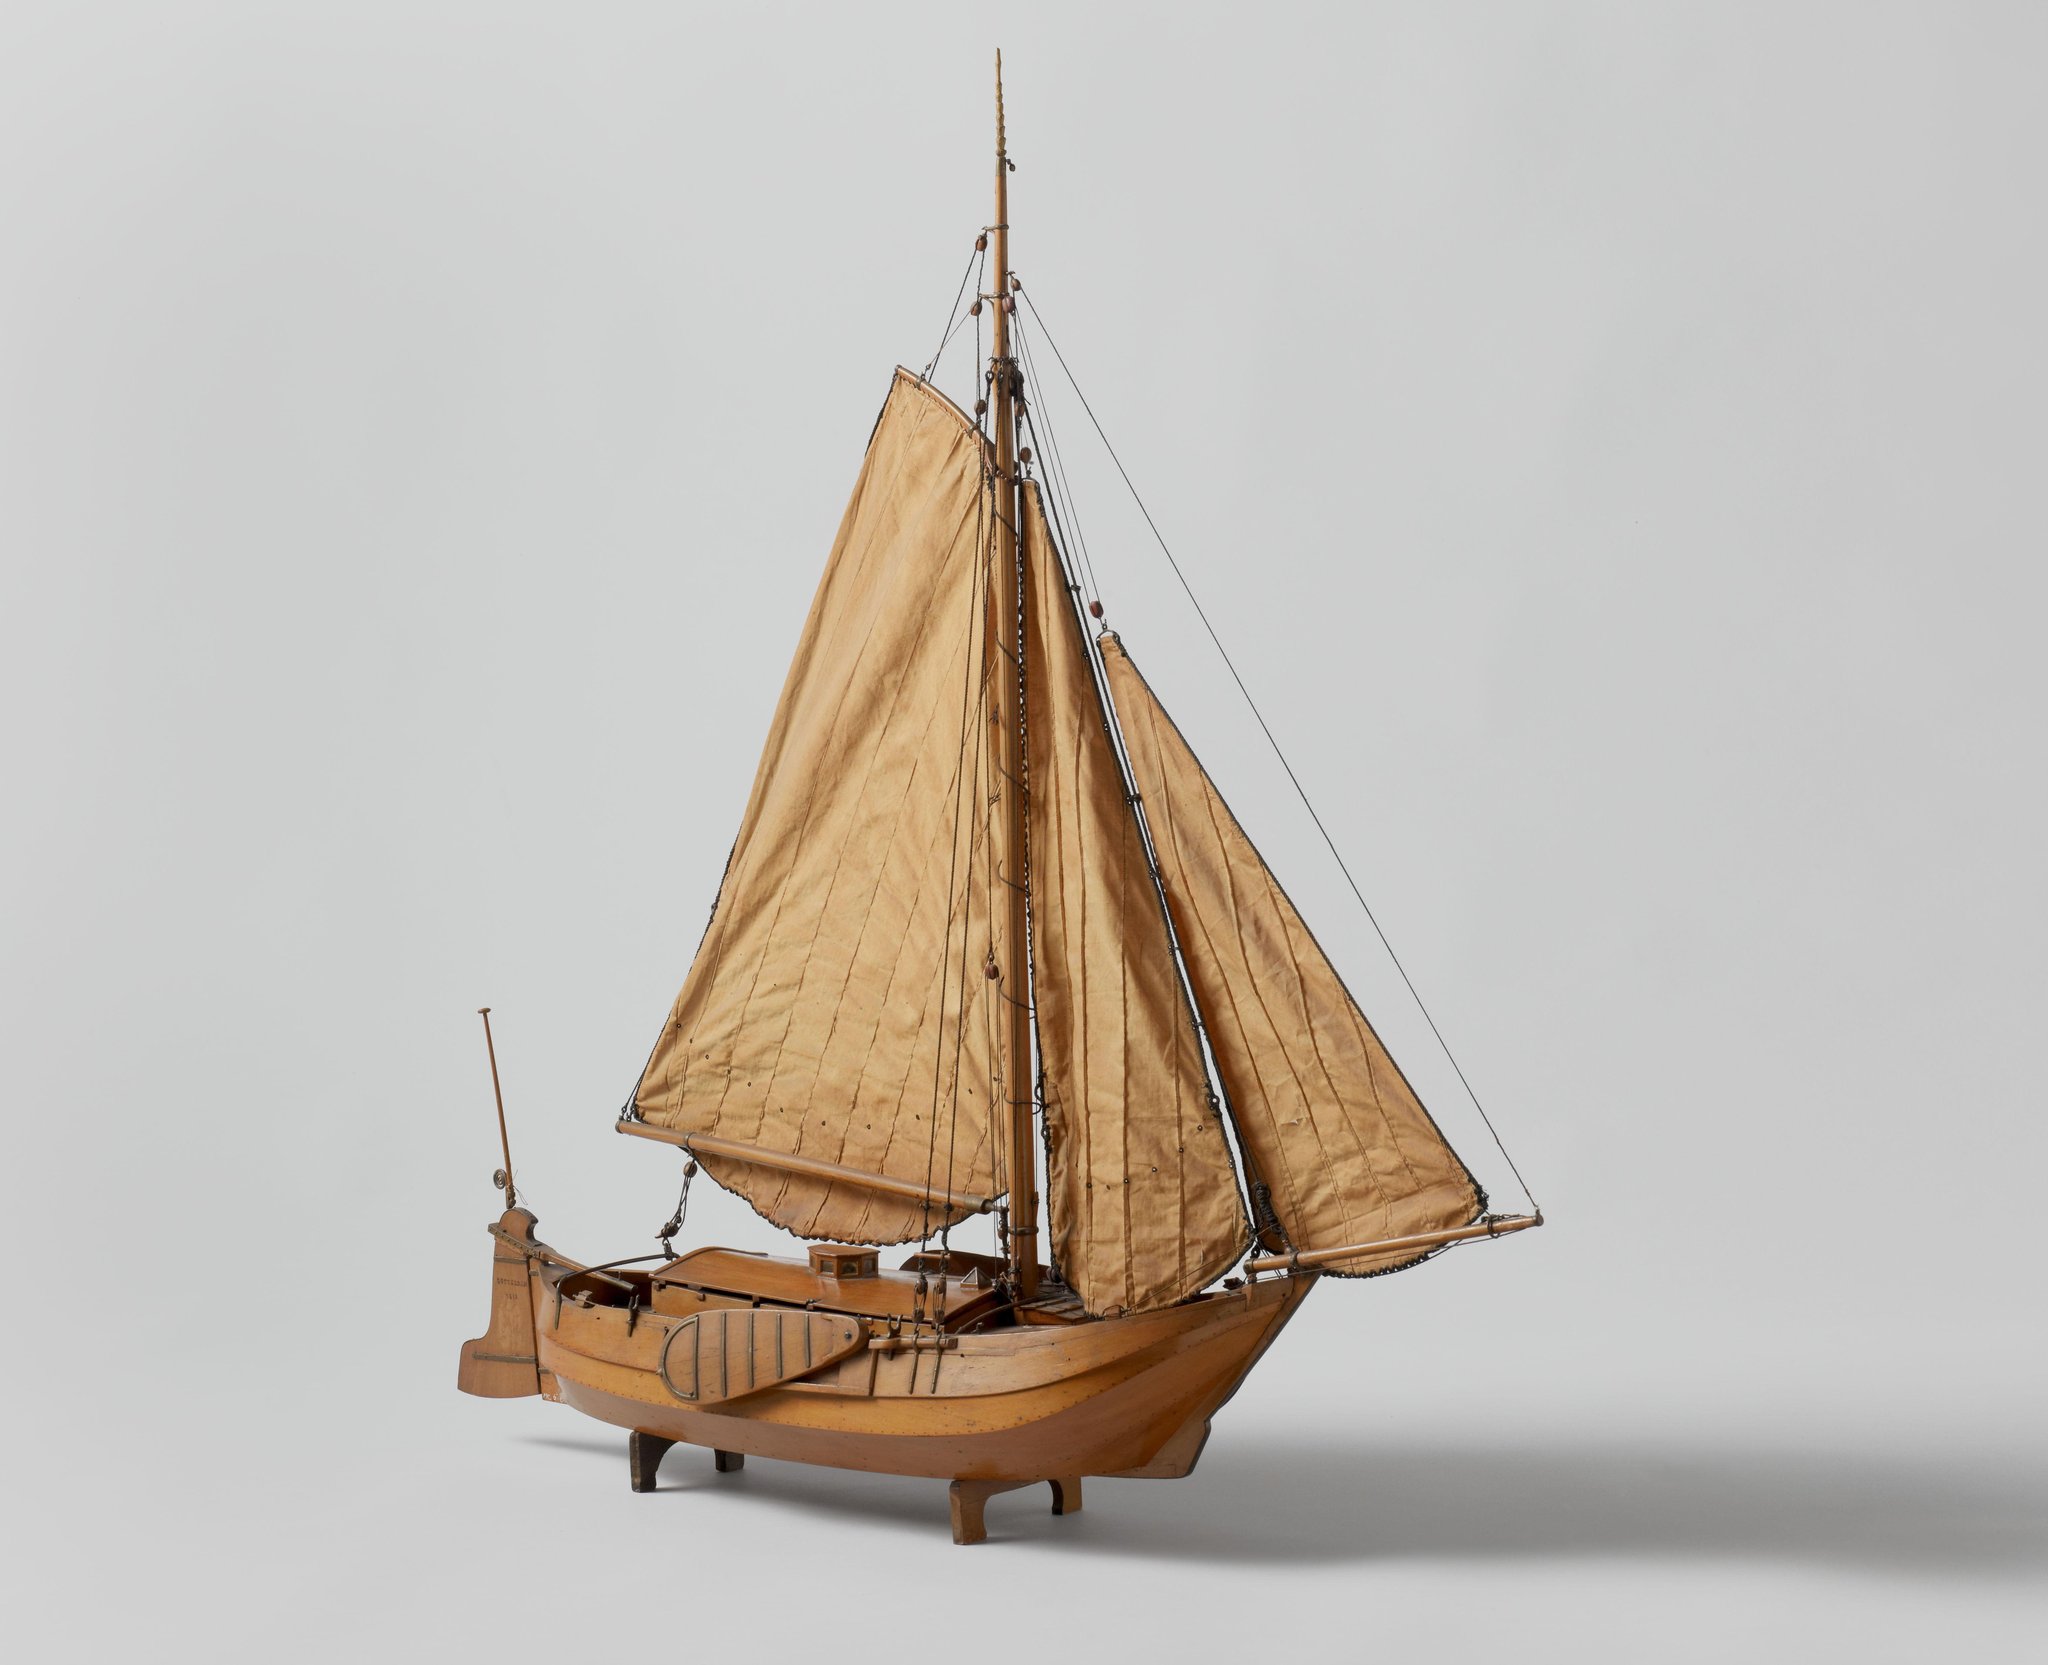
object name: ship model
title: Model of a Hengst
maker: Anonymous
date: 1819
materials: brass, lead, fiber, textile, wood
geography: rotterdam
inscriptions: inscription, on the rudder: ‘ROTTERDAM / 1819’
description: Een dergelijk hengst werd in het begin van de 19de eeuw gebruikt bij het Strijense Sas om de koninklijke familie naar de Moerdijk over te zetten. Hengsten werden meer als veerboten gebruikt: de oudste vermelding van een hengst betreft het proces-verbaal van 1711 betreffende de verdrinkingsdood van Johan Willem Friso tijdens het oversteken van het Hollands Diep. Dit model vertoont opvallende verschillen met de hengsten zoals door Petrejus en Van Beylen beschreven. Het model werd in 1882 in Londen tentoongesteld.